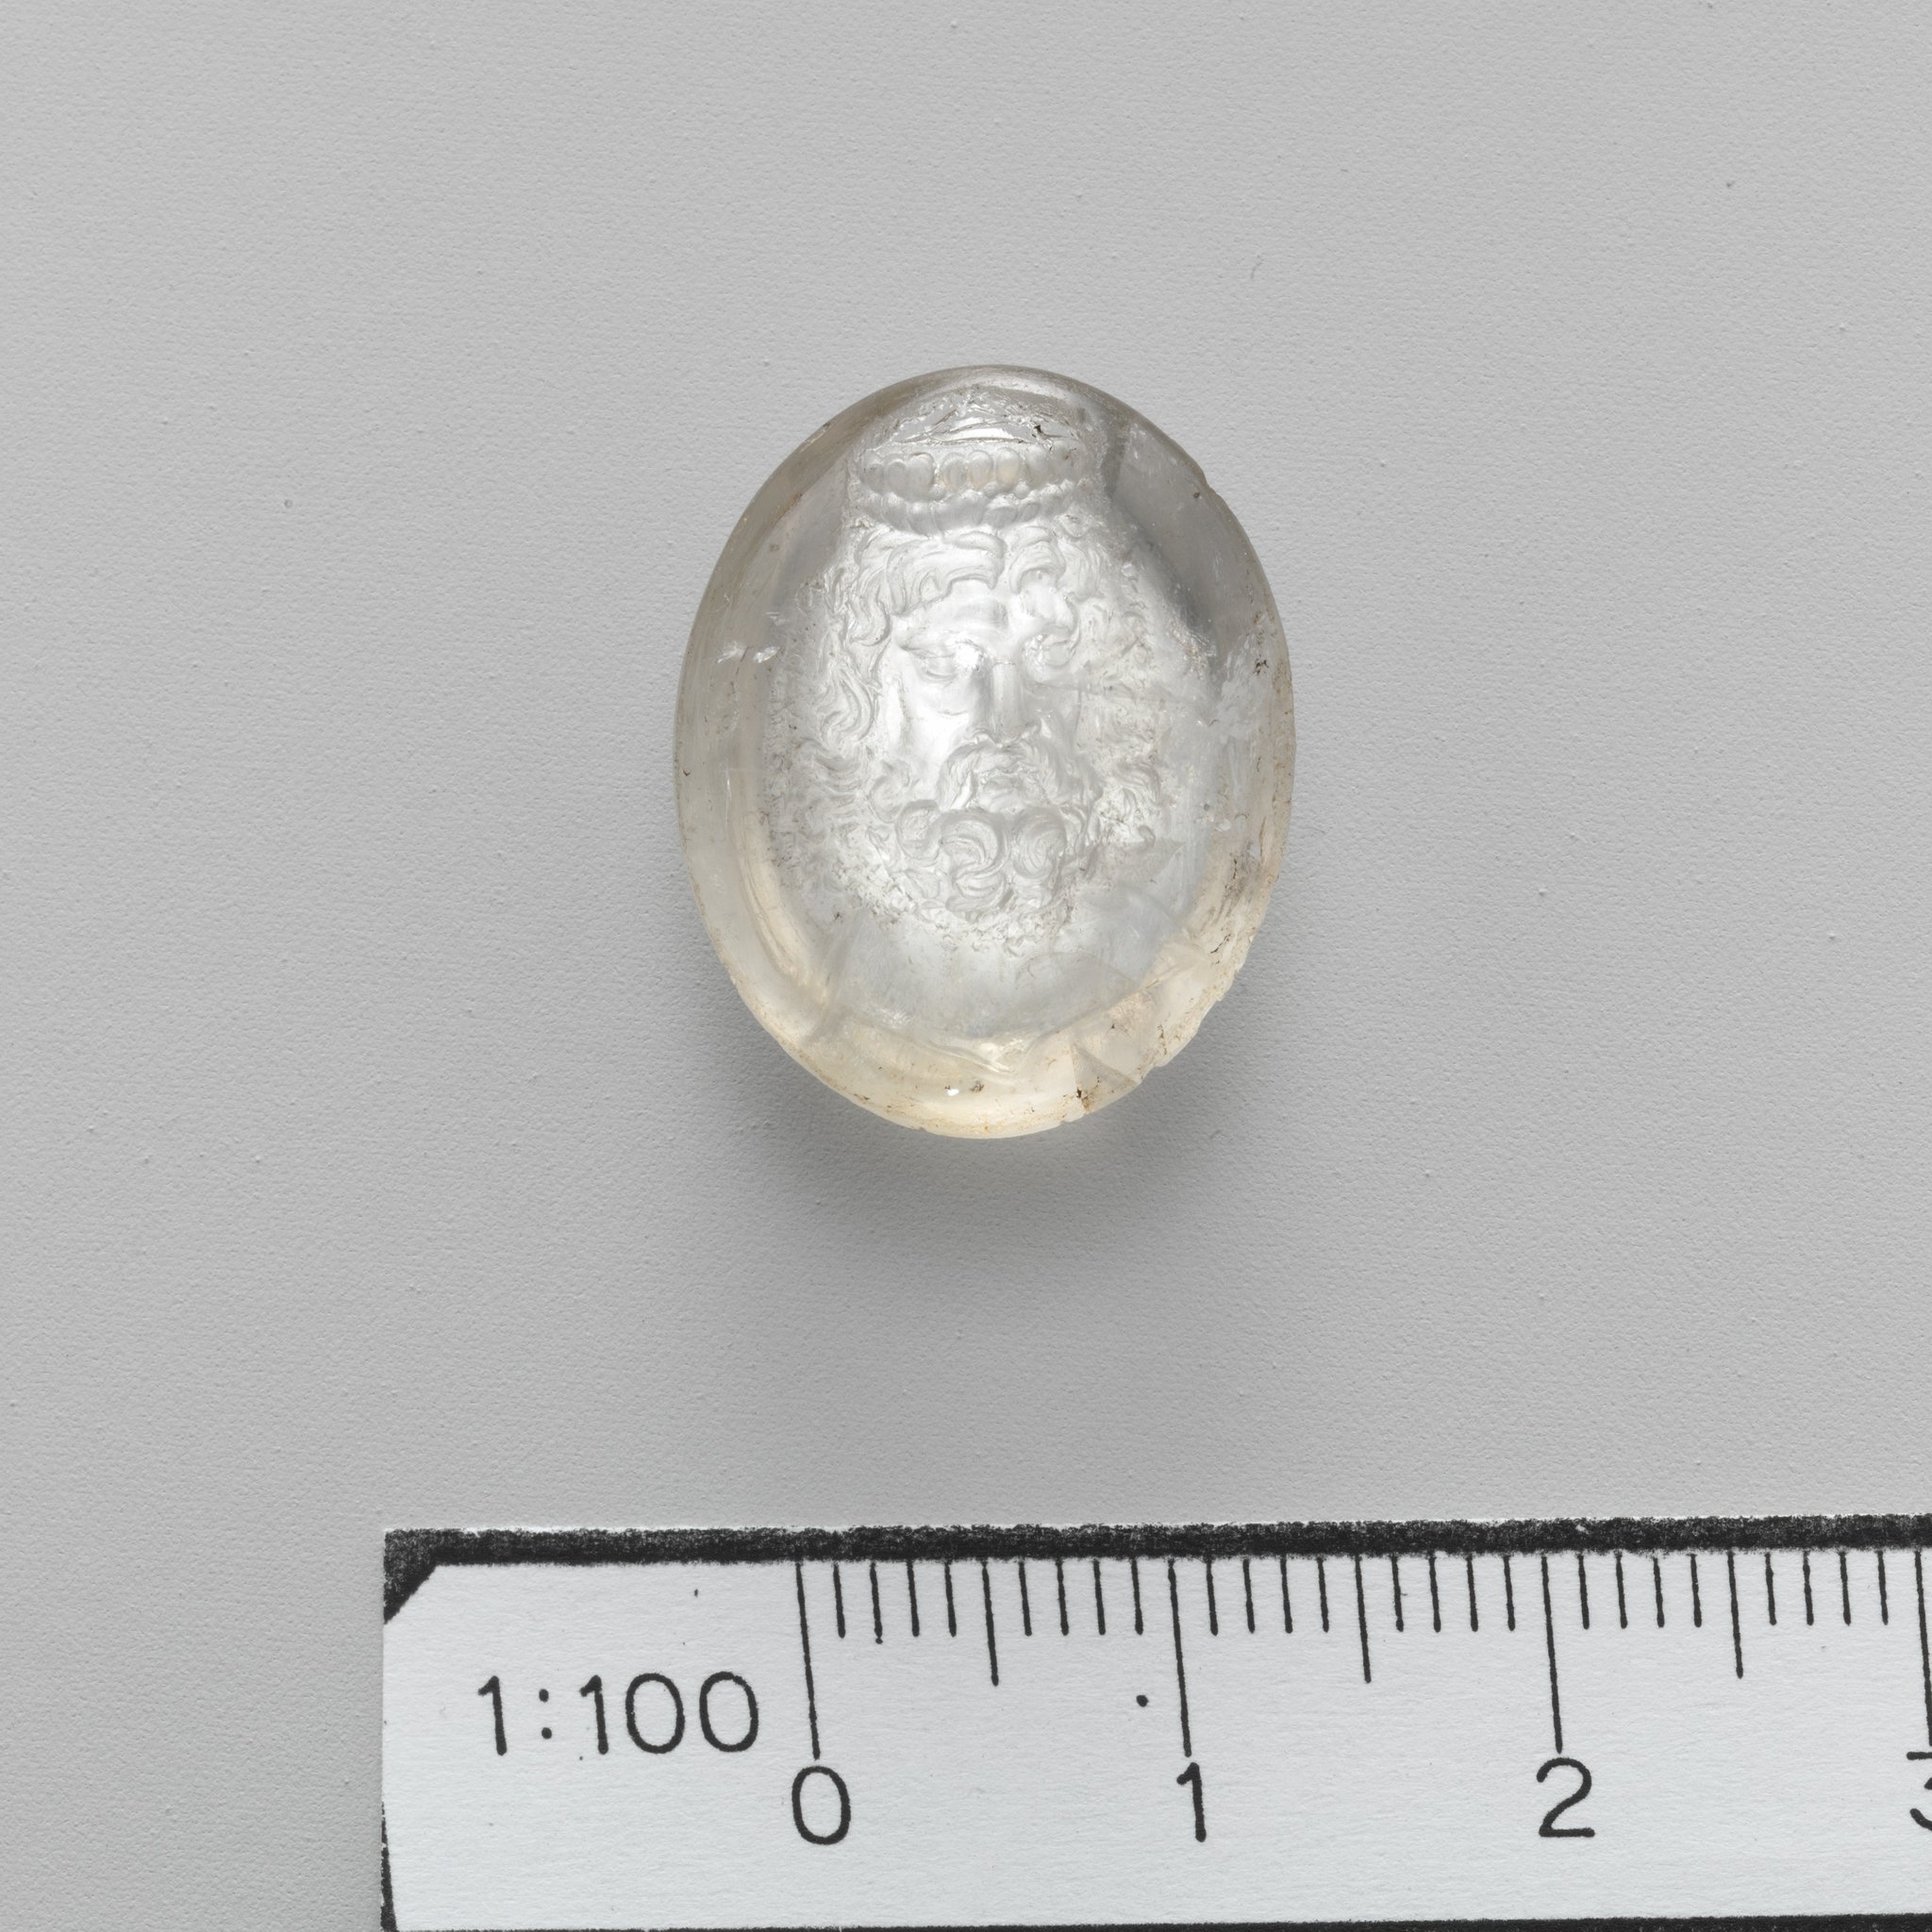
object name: intaglio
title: Rock crystal oval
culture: greek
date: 300-101 BCE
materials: quartz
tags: men